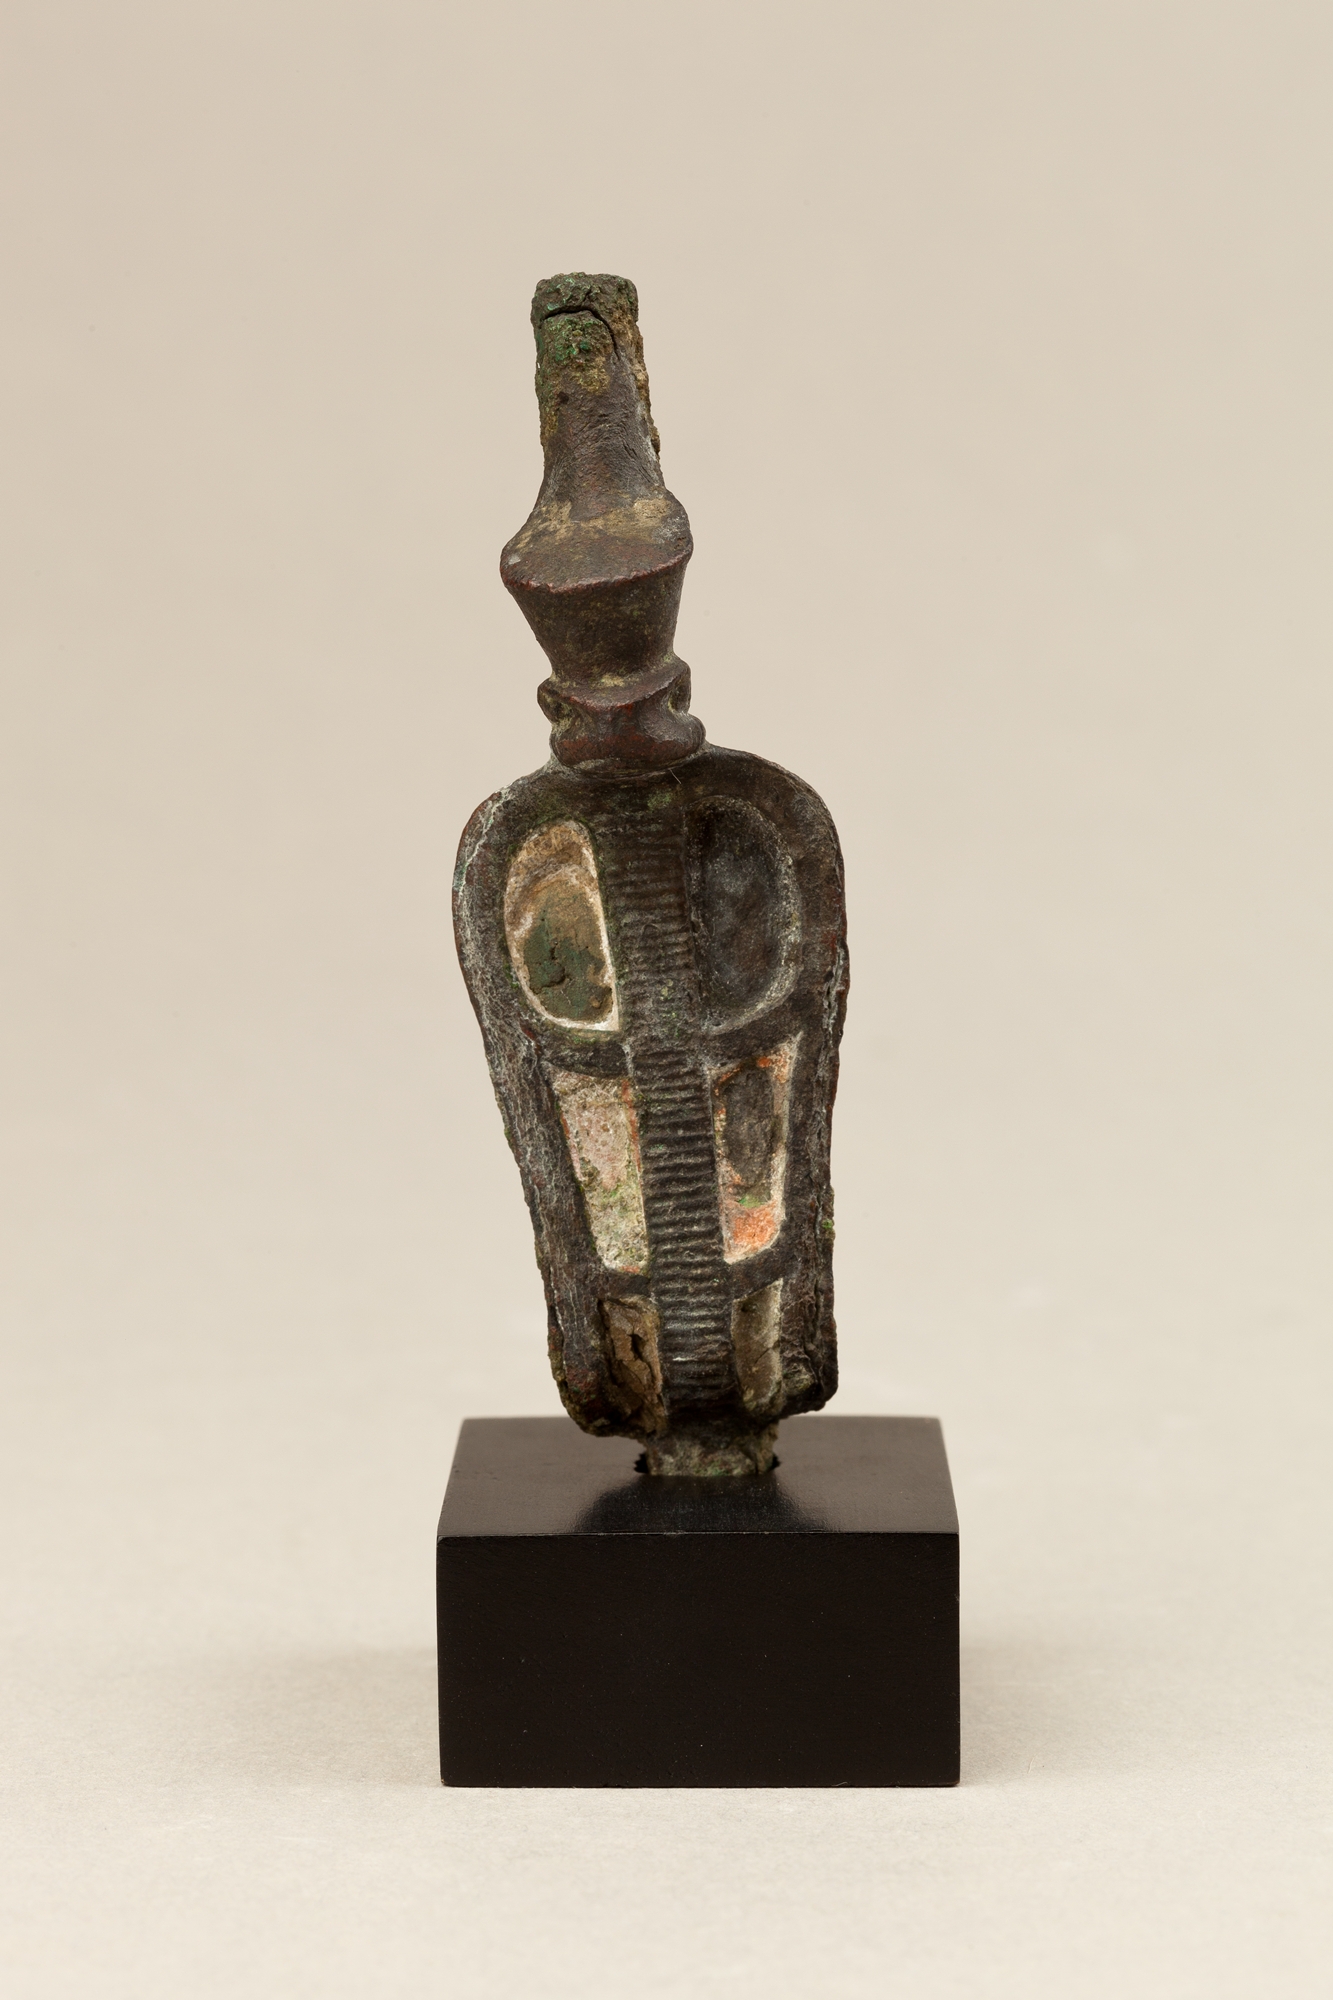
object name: uraeus, red crown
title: Uraeus with red crown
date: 664-630 BCE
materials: metal, glass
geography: egypt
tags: snakes